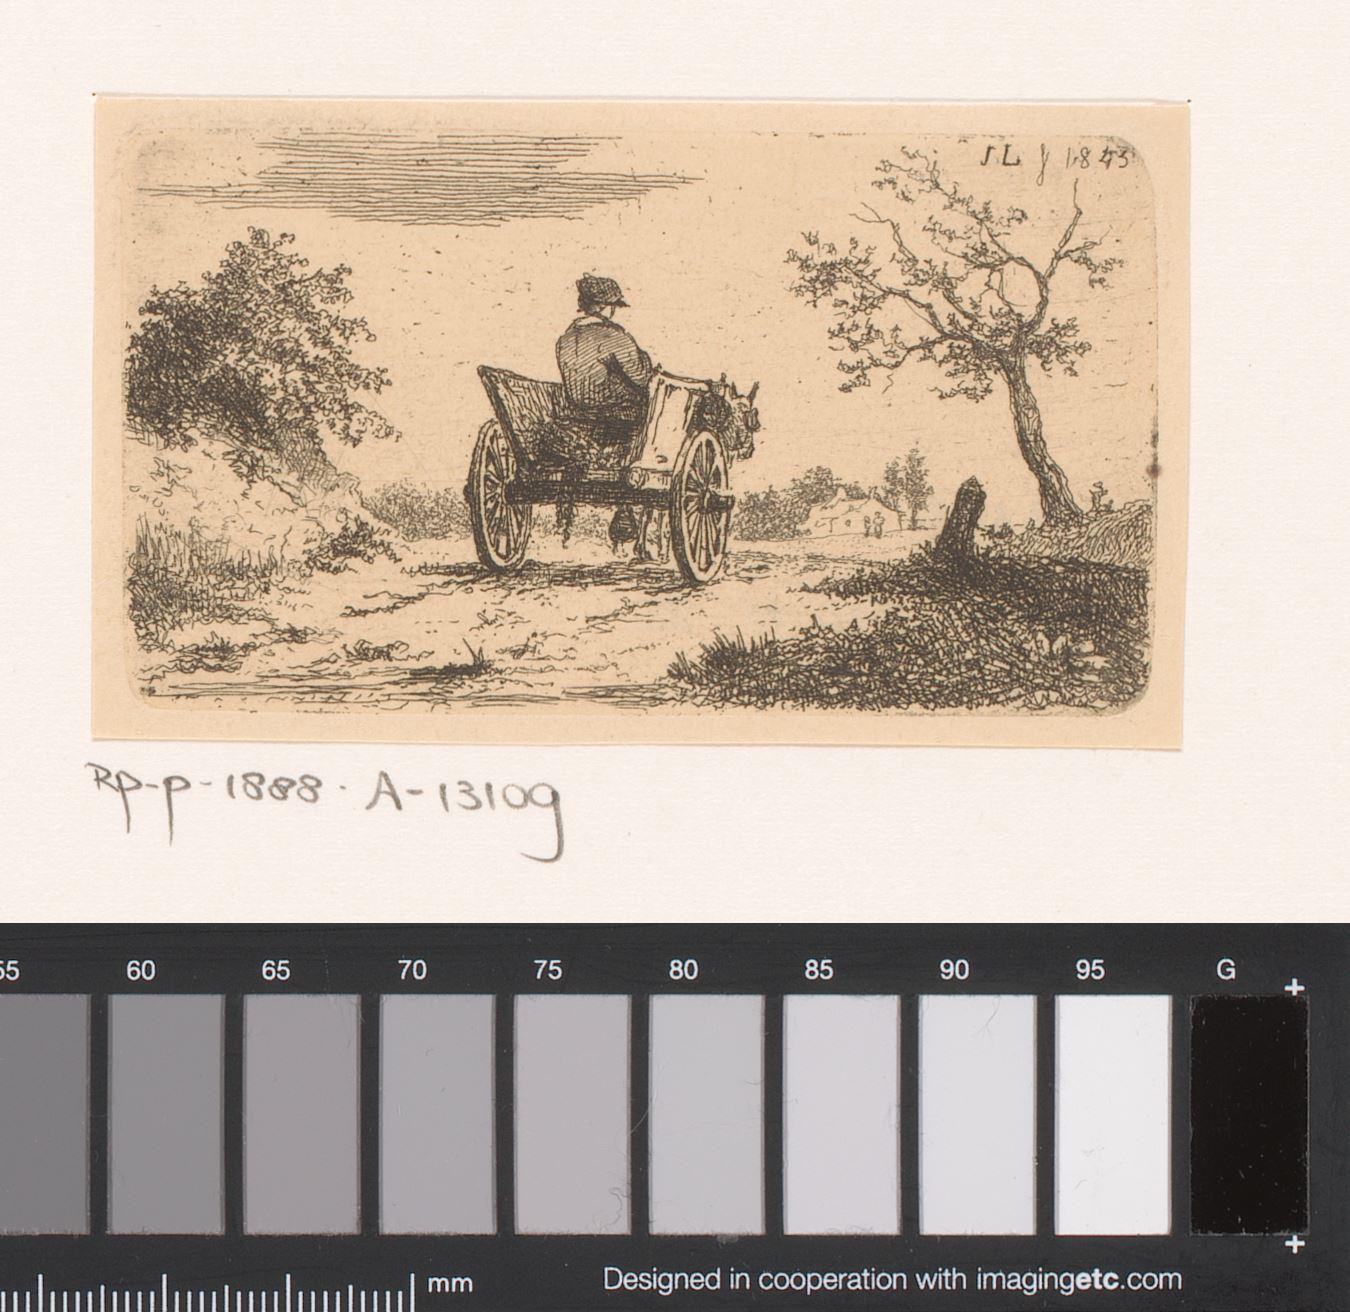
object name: print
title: Man op een boerenwagen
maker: jean théodore joseph linnig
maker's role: draughtsman, print maker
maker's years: 1815-1891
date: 1843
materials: paper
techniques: etching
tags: two-wheeled vehicle drawn by one animal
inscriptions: collector's mark: Lugt 2228